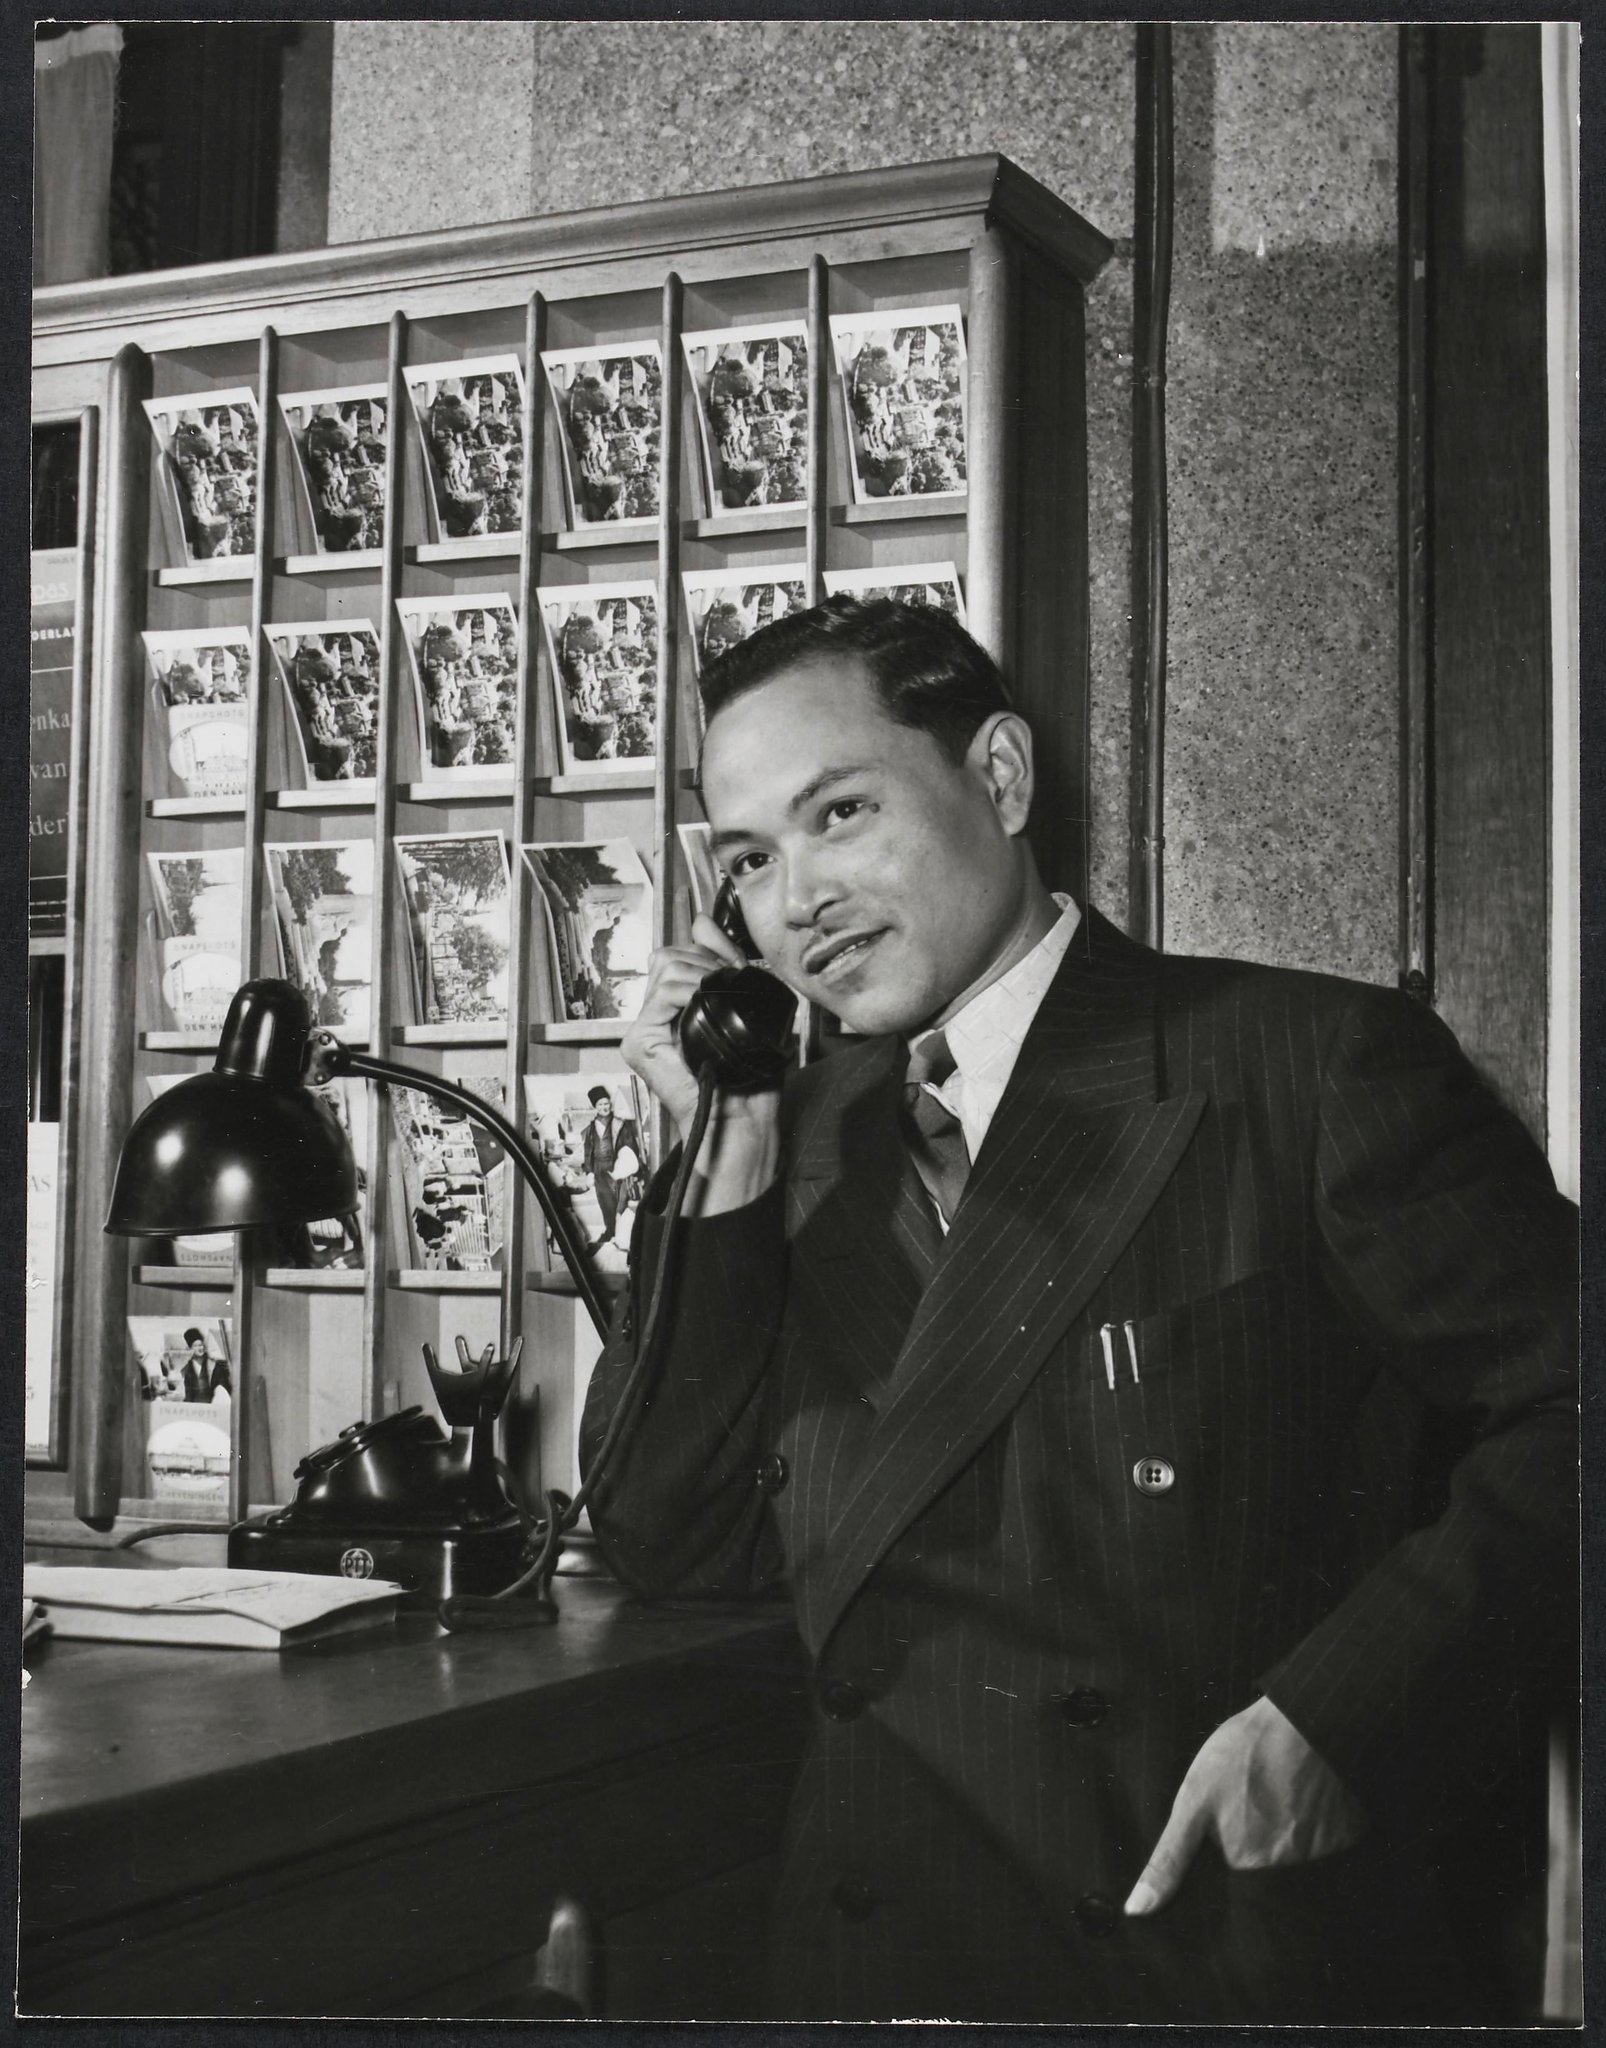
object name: documentary photograph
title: Surinamers in Nederland: 29 foto's uit het archief van Ons Vrije Nederland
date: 1902-1948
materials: photographic support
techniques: photography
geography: the hague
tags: historical persons, netherlands, suriname, the hague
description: Een van de deelnemers namens Suriname aan de Ronde Tafel Conferentie tussen Nederland en de West: de politicus Salikin M. Hardjo tijdens een telefoongesprek. Hij is voorzitter van "Pergerakan Bangsa Indonesia Indonesia", een partij voor Javanen in Suriname, en werkt bij de medische voorlichting.